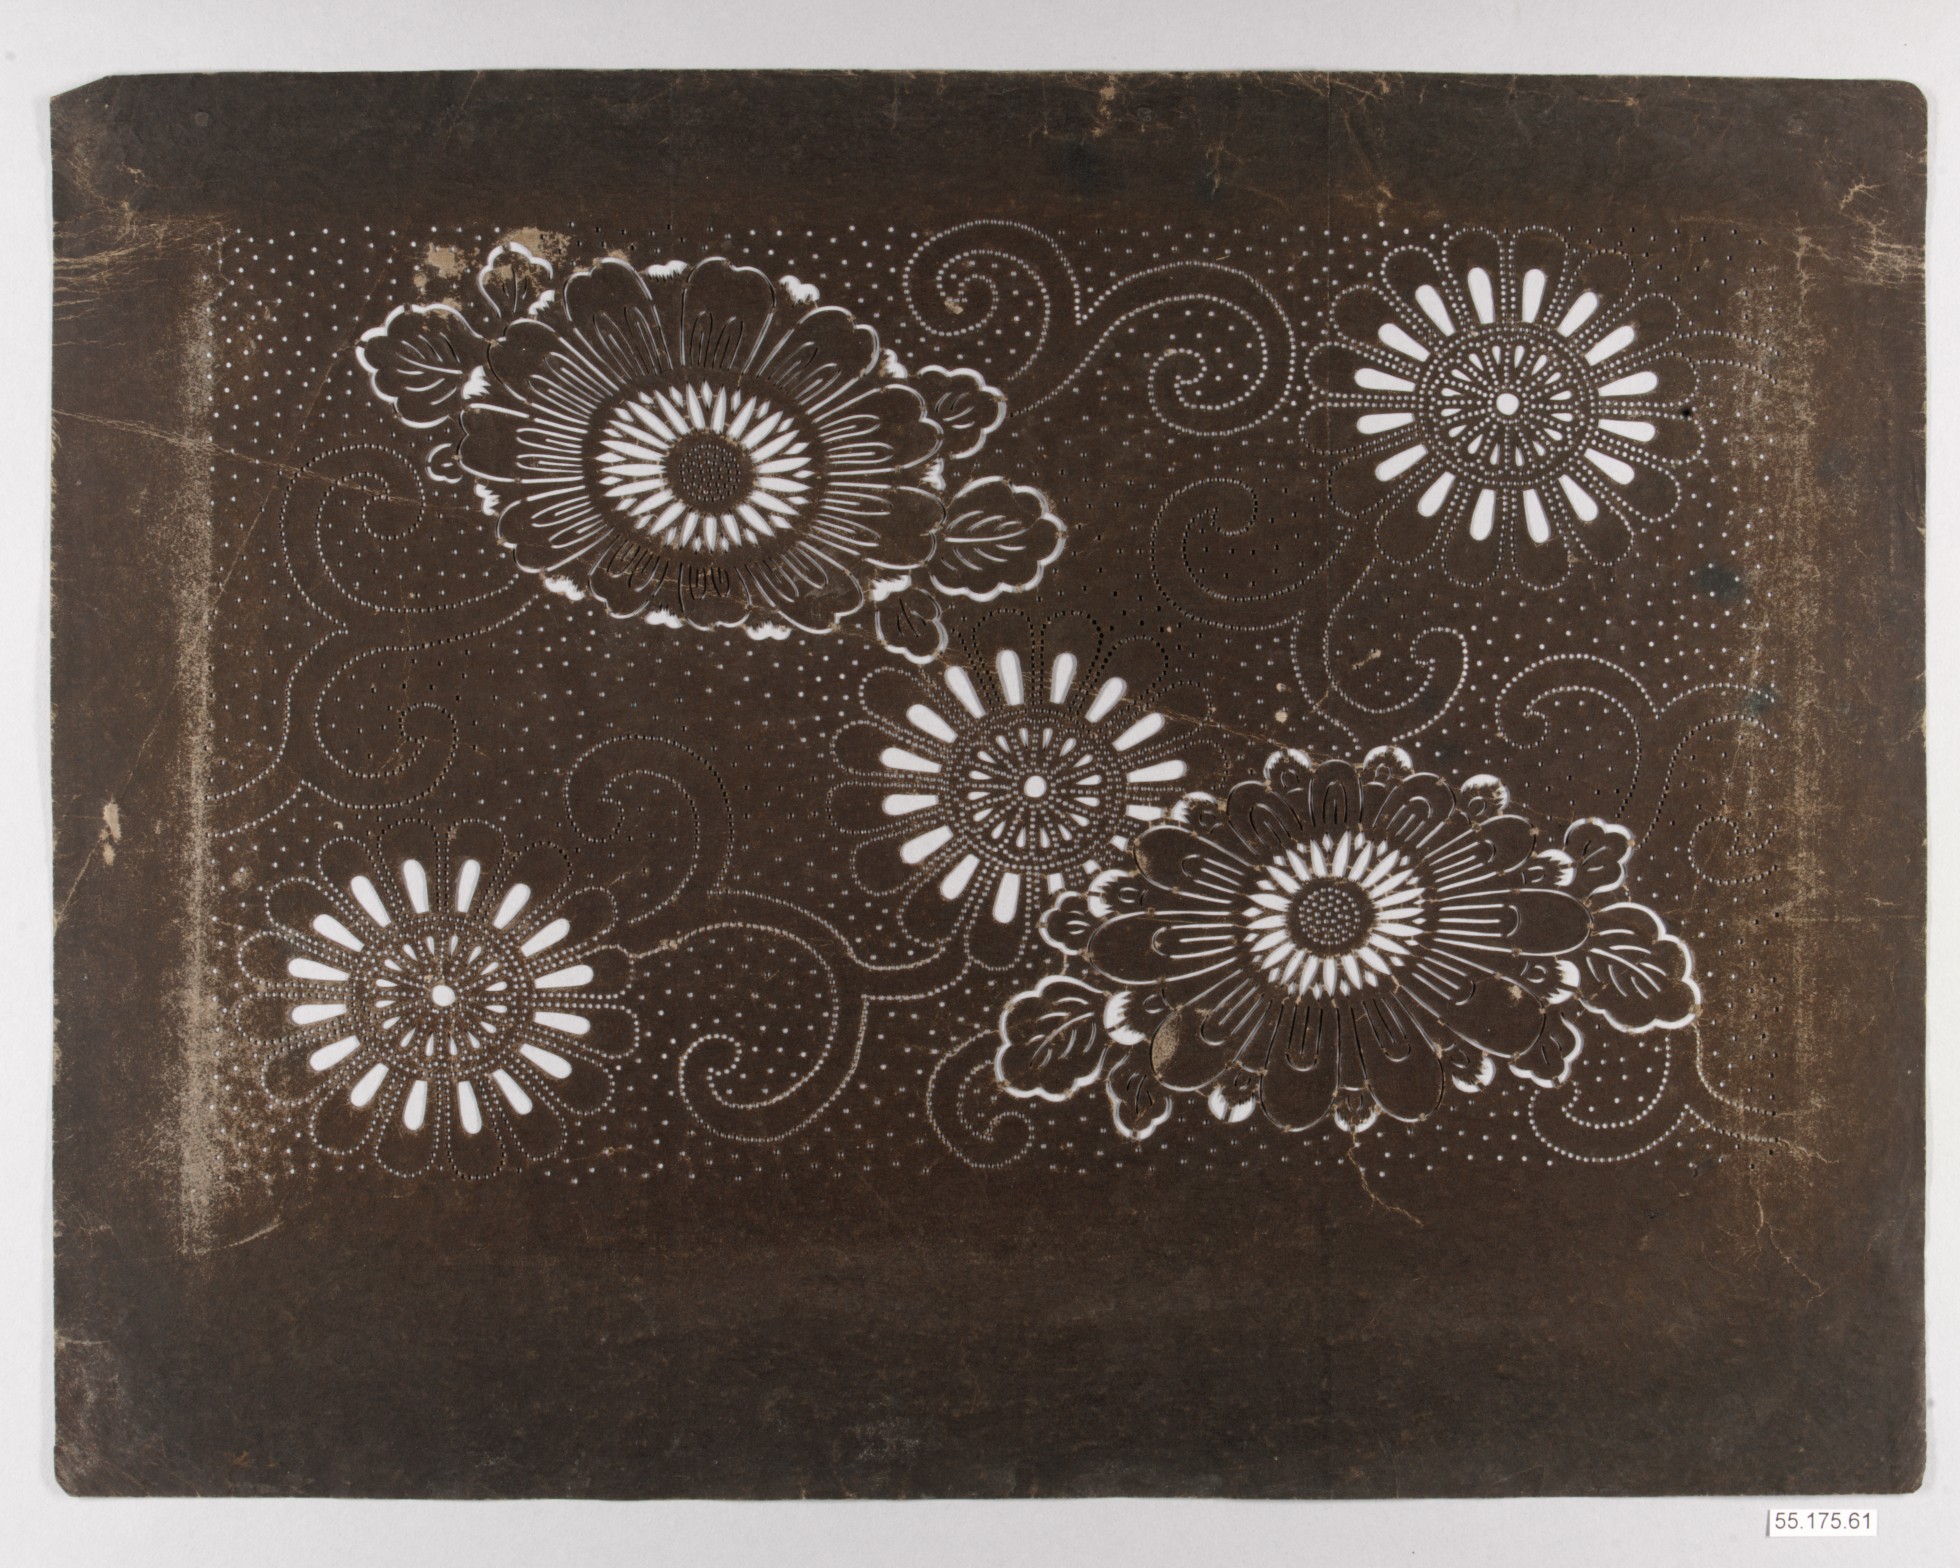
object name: stencil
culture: japanese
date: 1801-1900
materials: paper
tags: flowers